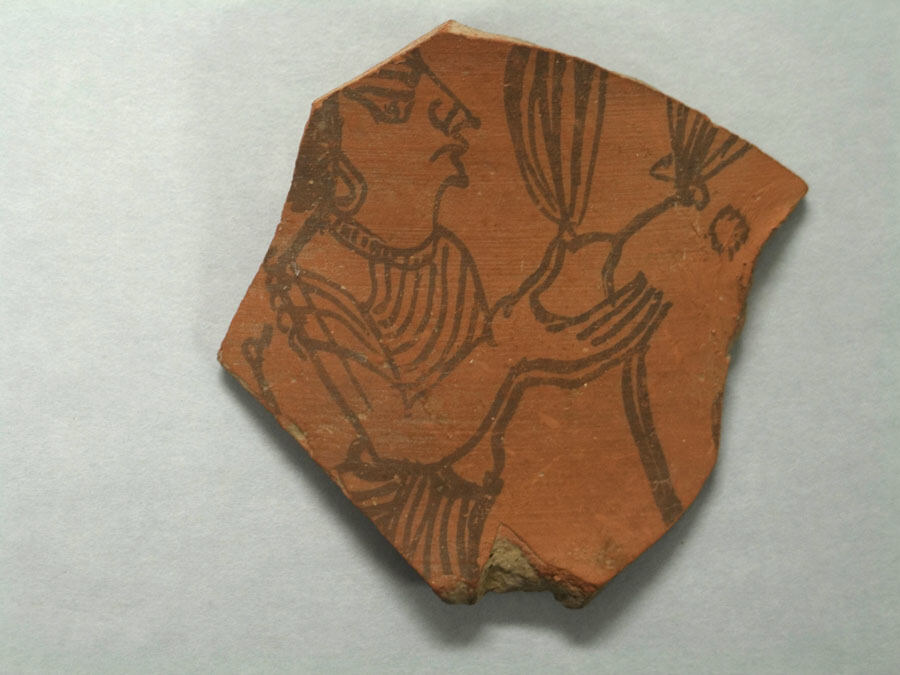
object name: shard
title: Shard: Offerer with Flower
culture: pakistani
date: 301-500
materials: terracotta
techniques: painting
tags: human figures,gandhara